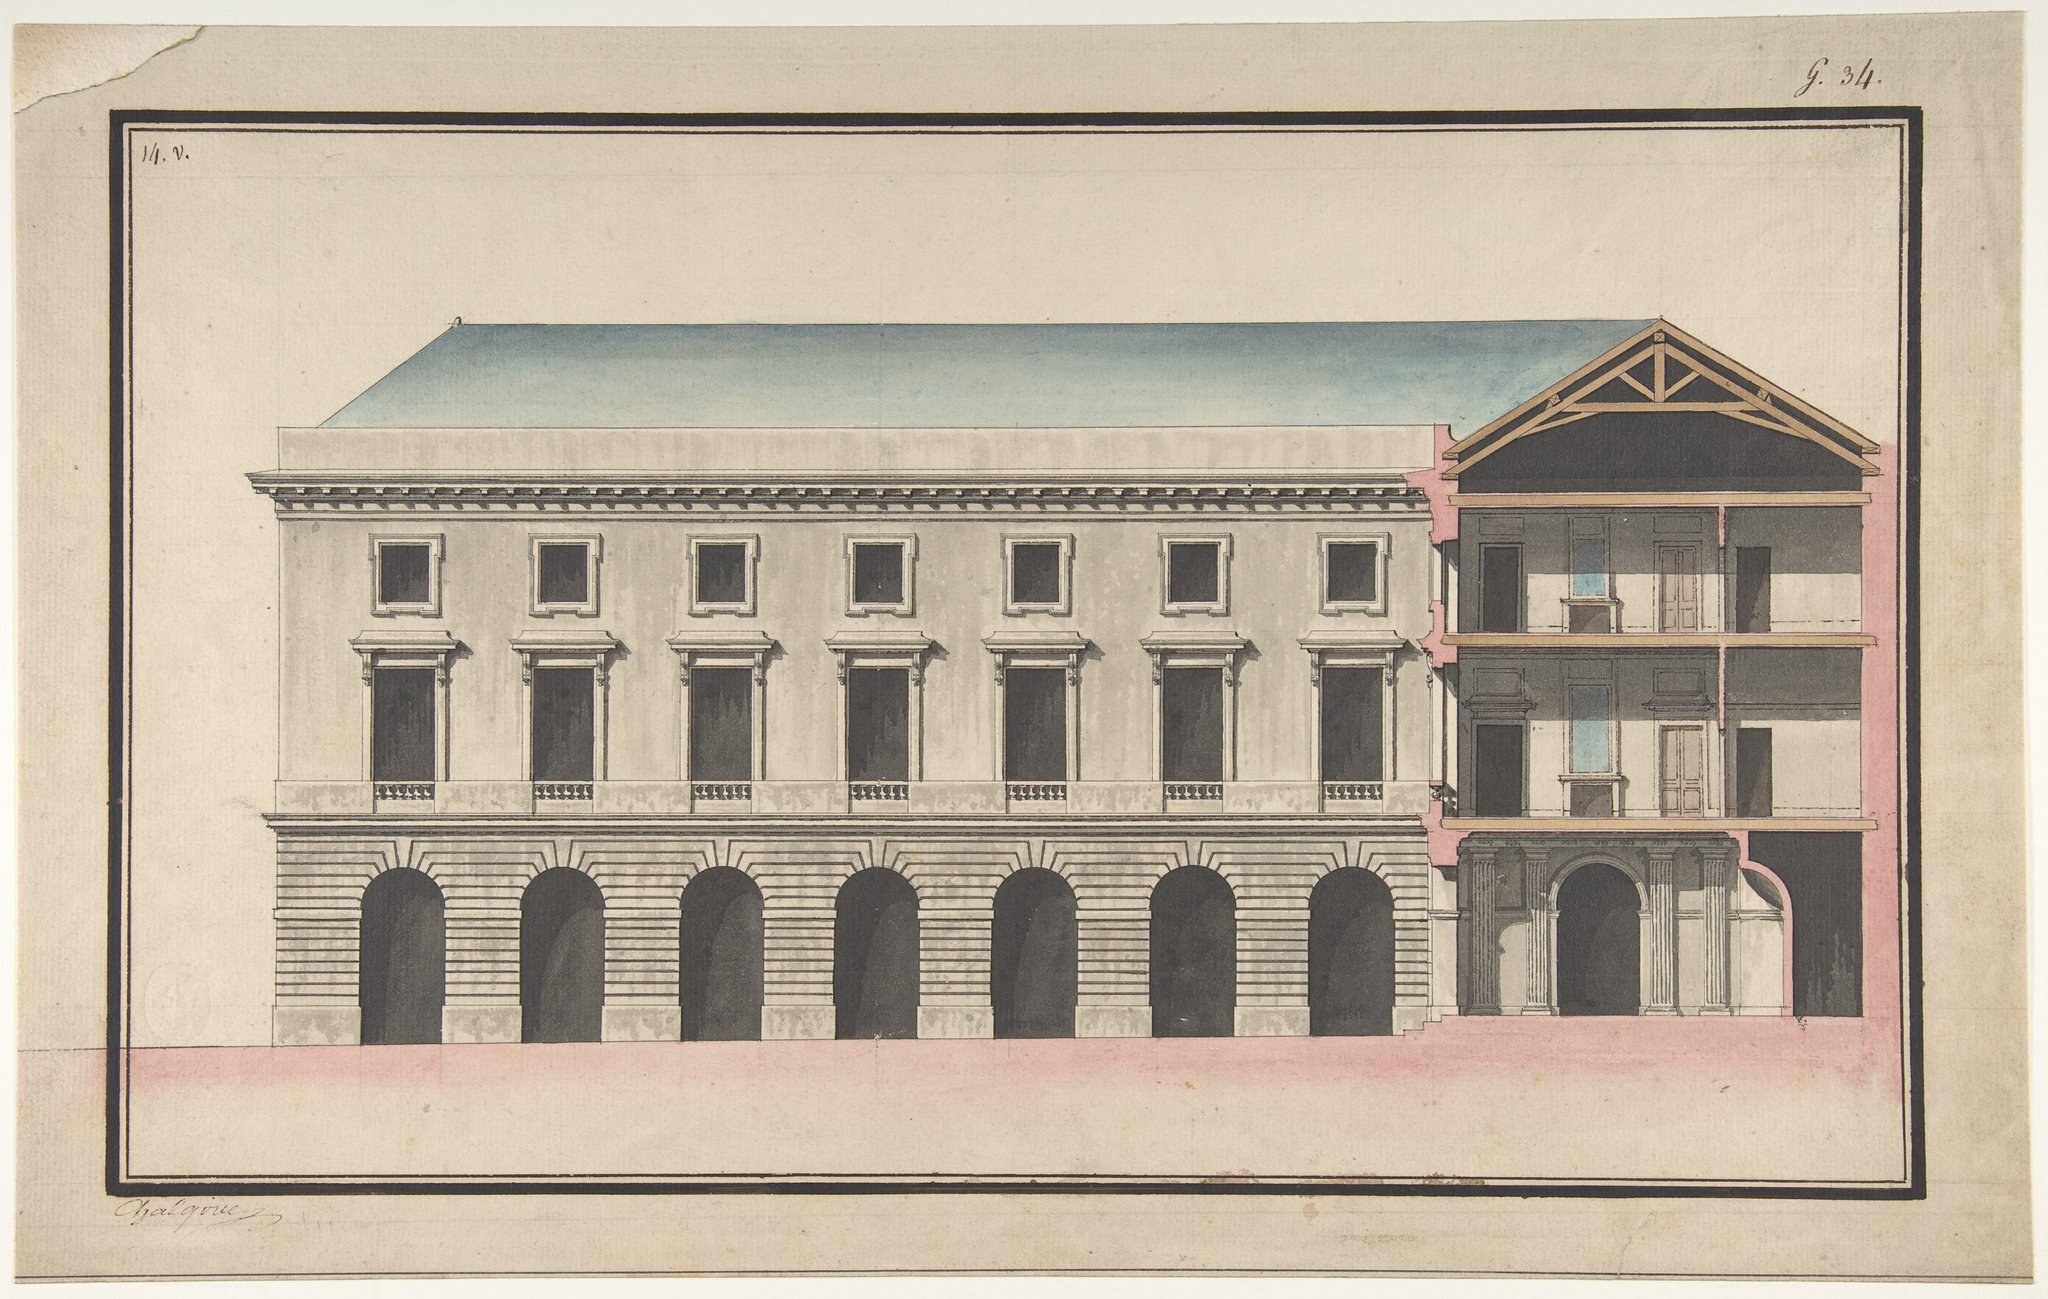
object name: drawing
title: Design for the Collège de France, Paris: Elevation of the Wings of the Court with a Transverse Section through Main Front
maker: jean françois chalgrin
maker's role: artist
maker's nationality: french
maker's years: 1739-1811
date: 1772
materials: graphite, ink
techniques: brush, pen, drawing, wash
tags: architecture,buildings